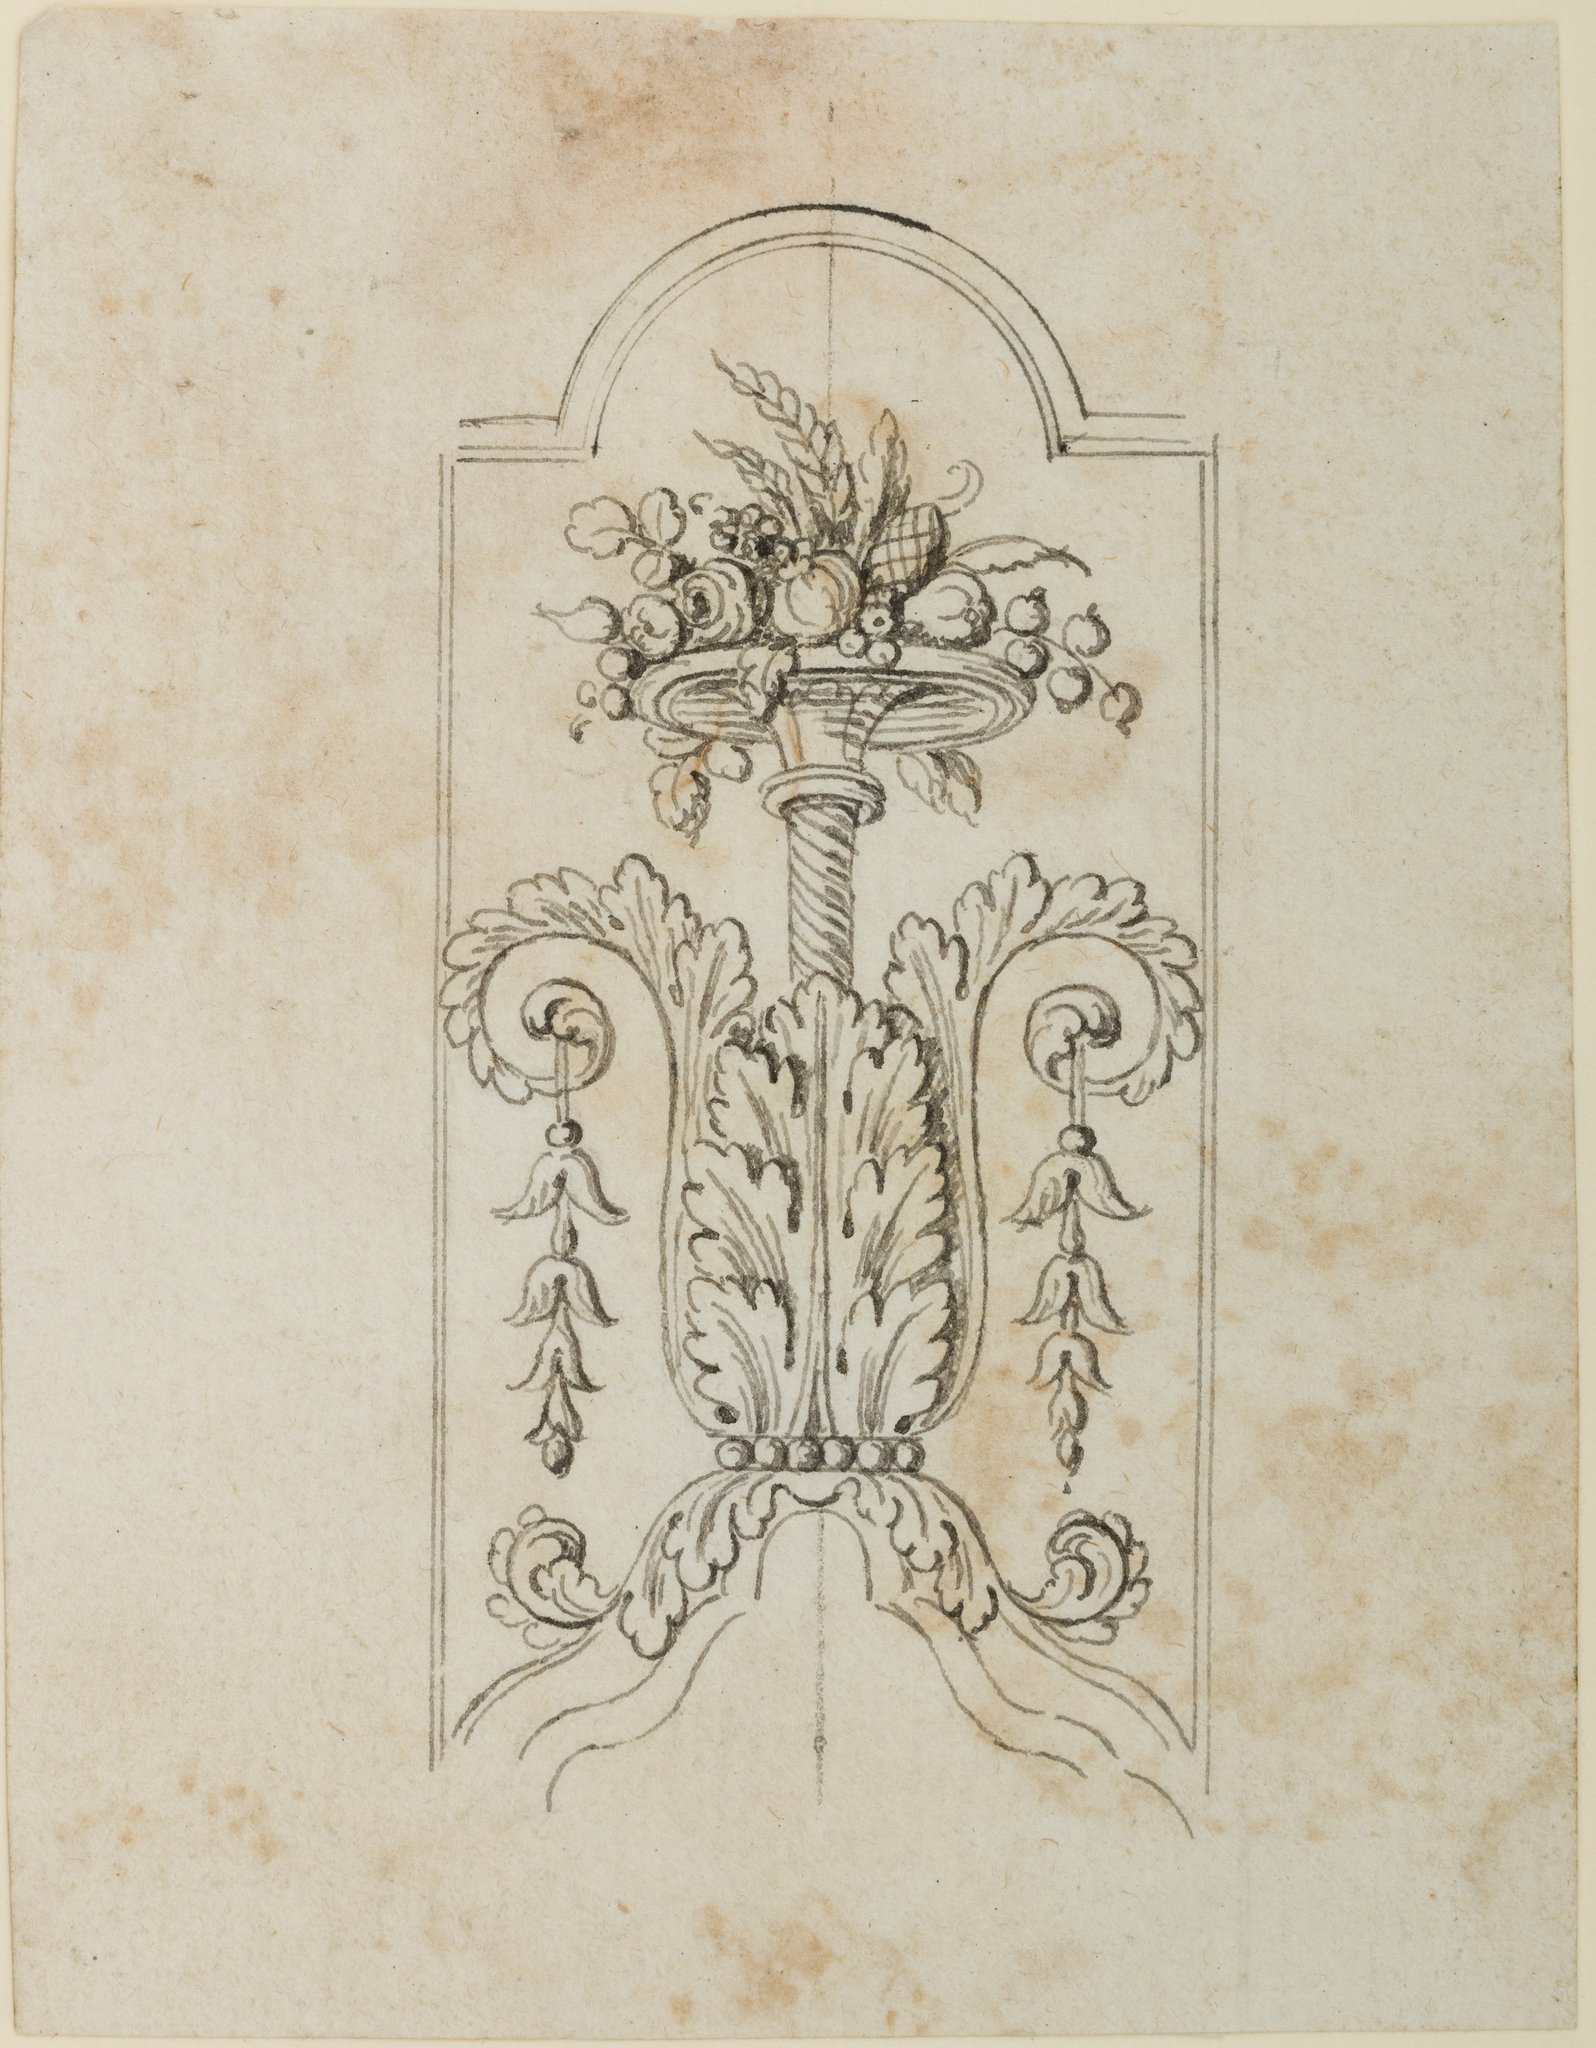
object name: drawing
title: Design for the Decoration of Firearms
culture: french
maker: nicolas noël boutet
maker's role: designer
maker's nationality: french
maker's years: 1761-1833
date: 1797-1805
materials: ink, paper, pencil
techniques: wash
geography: france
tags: ornament